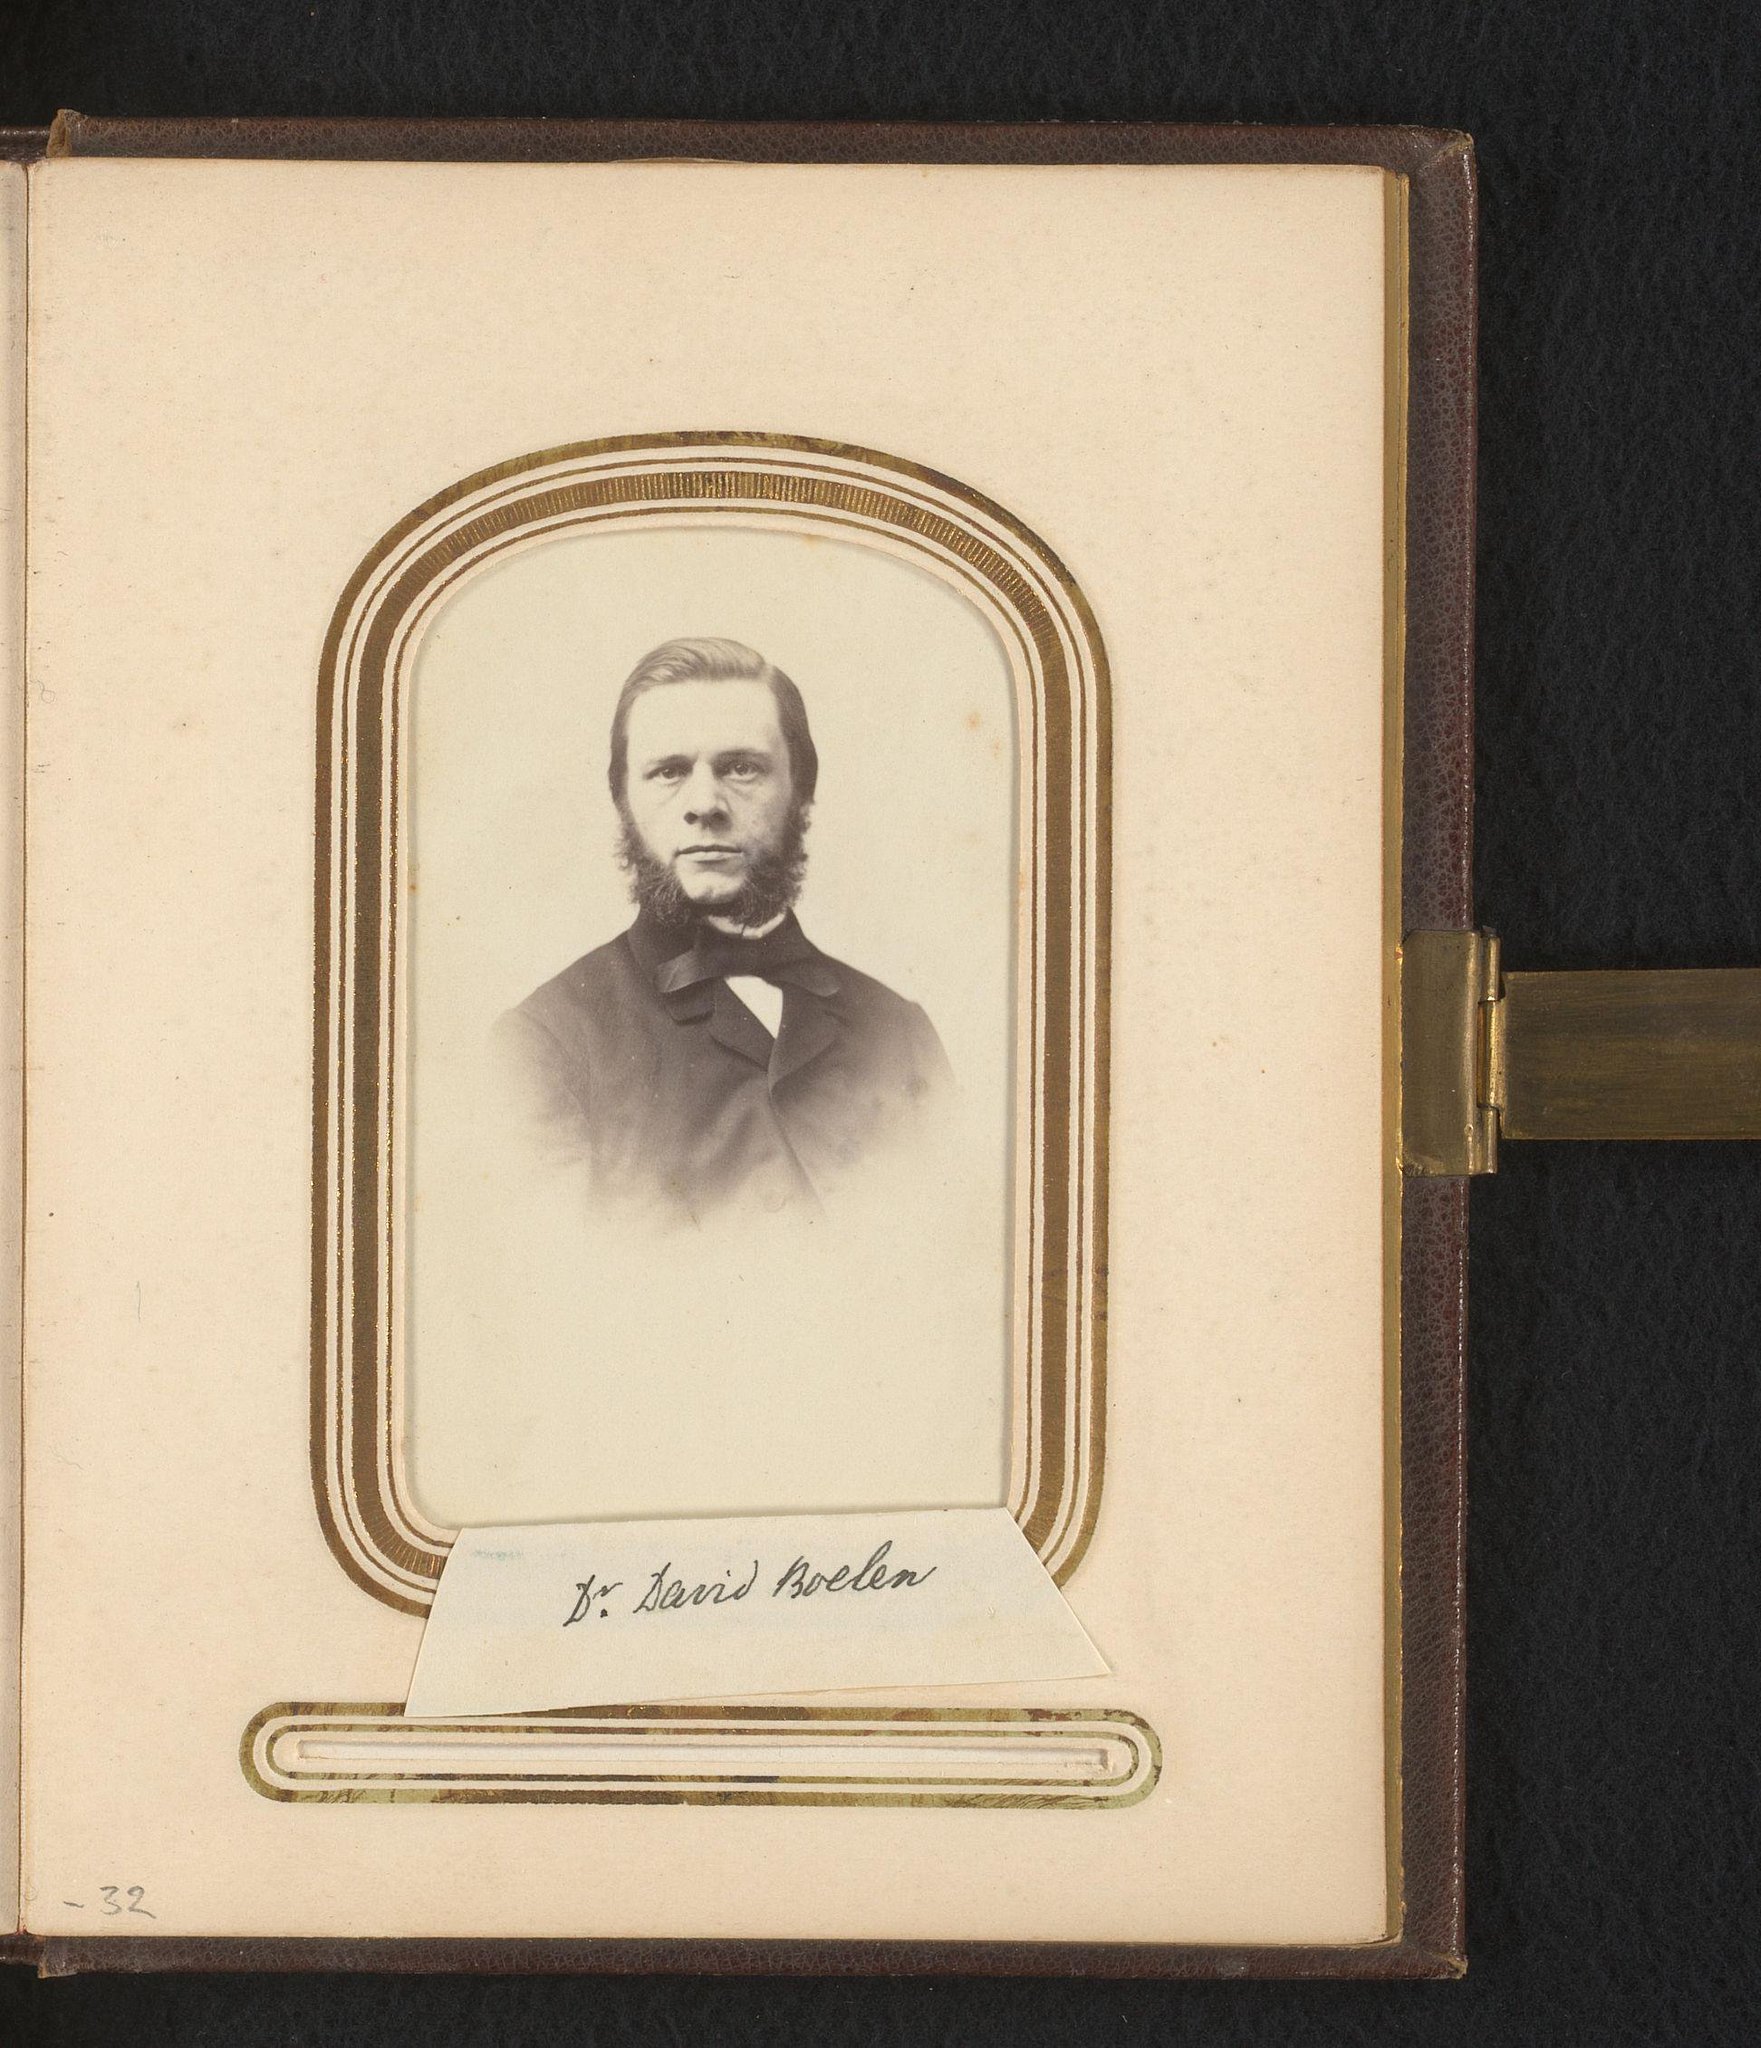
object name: album leaf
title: Dr. David Boelen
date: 1864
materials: cardboard, paper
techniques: albumen print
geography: amsterdam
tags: historical persons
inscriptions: address: ‘AMSTERDAM/ Achtergracht bij den Amstel/ Z 183.’